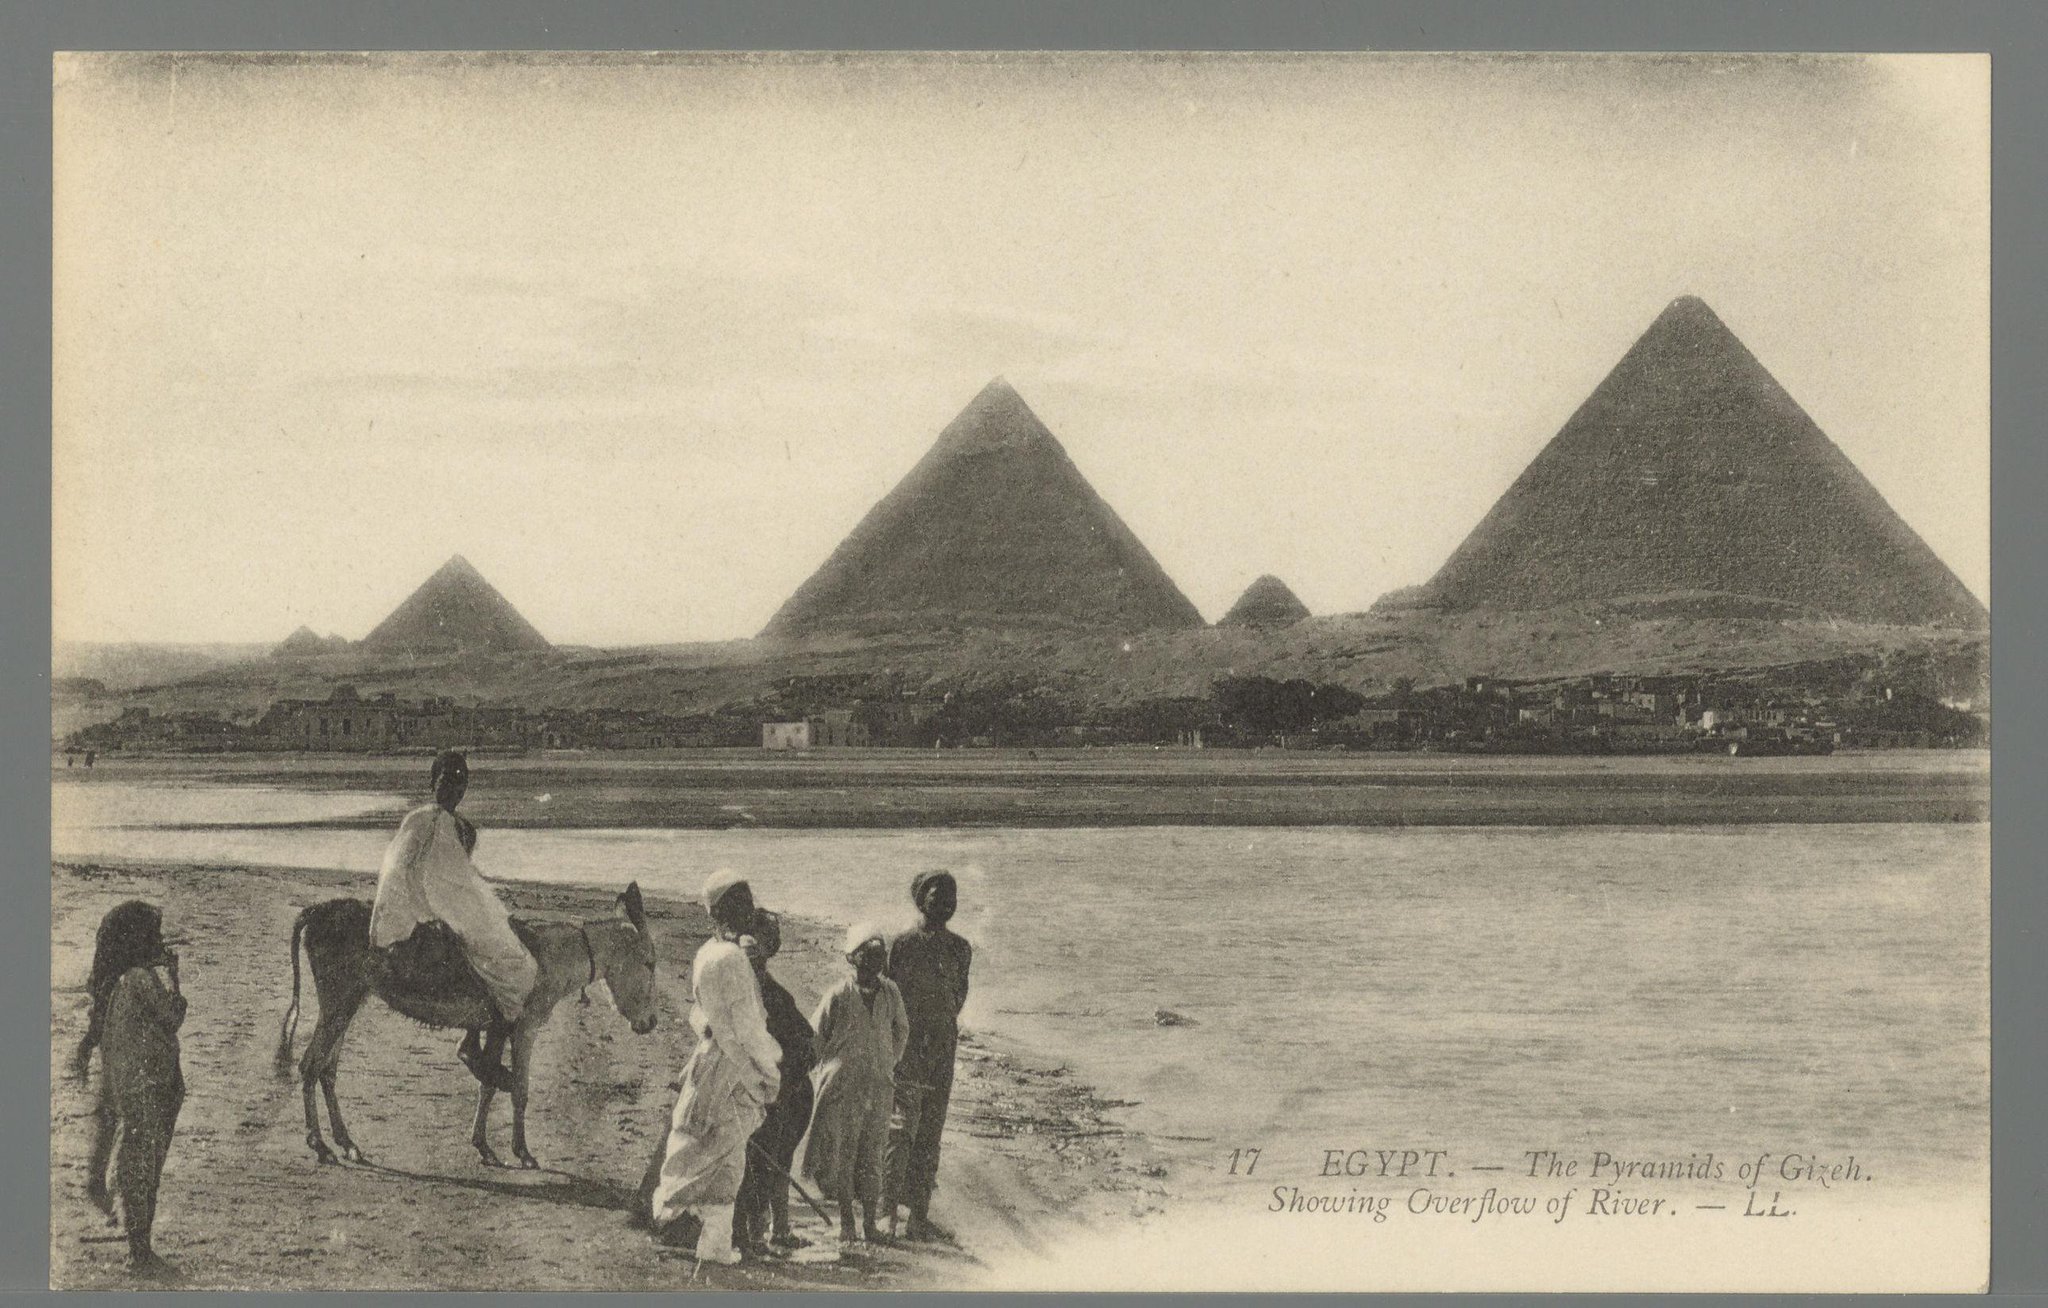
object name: ansichtkaart, prentbriefkaart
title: Egypt - The Pyramids of Gizeh. Showing overflow of river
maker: Anonymous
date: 1907-1930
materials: cardboard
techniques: photograph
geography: gizeh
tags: river, quadrangular pyramid, desert